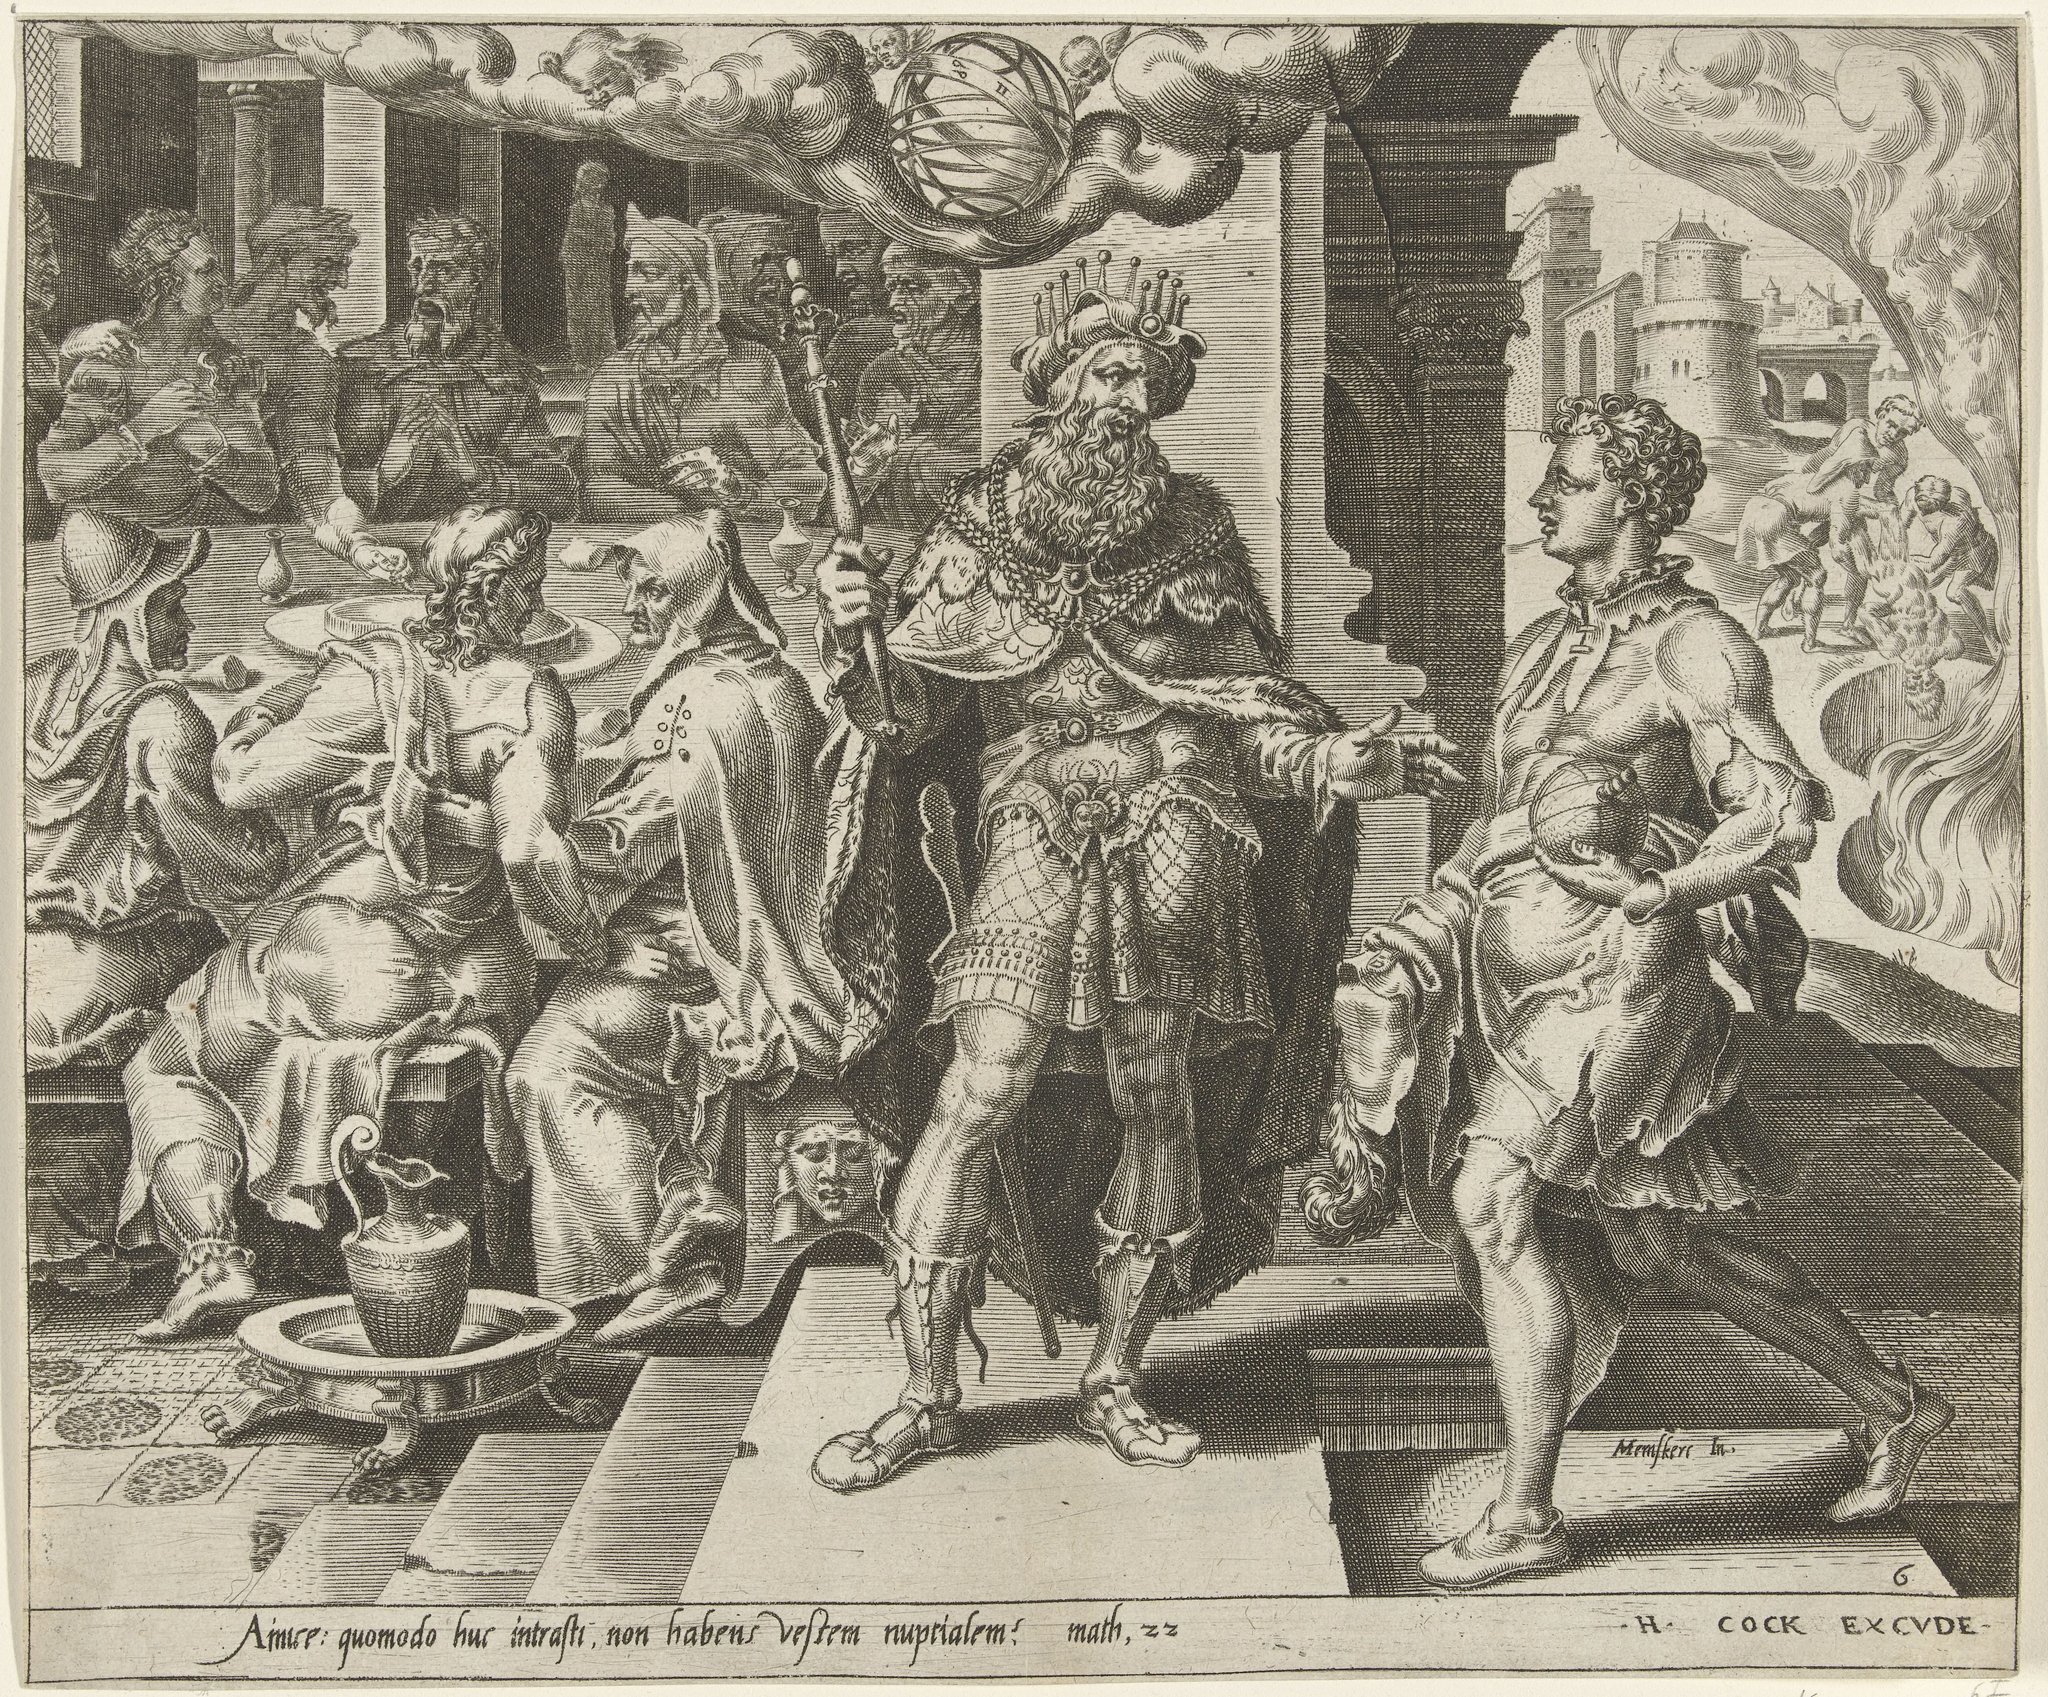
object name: print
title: Bestraffing van de man zonder bruiloftskleding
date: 1558-1559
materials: paper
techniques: engraving, etching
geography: antwerp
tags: armillary sphere, skeleton celestial globe, the king sees a guest without a wedding garment: 'bind him hand and foot .. and cast him into the outer darkness' ~ parable of the royal wedding-feast, wine-cooler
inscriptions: collector's mark: Lugt 2228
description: Een bruiloftsfeest waar de gasten zich tegoed doen aan een maaltijd. Een man zonder bruiloftskleren wilt zich bij het bruiloftsfeest voegen maar wordt tegengehouden door de koning die het feest heeft georganiseerd. Hij is van oordeel dat "velen geroepen zijn, maar slechts weinigen uitverkoren"(Matt. 22:14). Op de achtergrond wordt de man gestraft door hem in het hellevuur te gooien. De prent heeft een Latijns onderschrift en maakt deel uit van een zesdelige serie over de gelijkenis van een bruiloftsfeest.